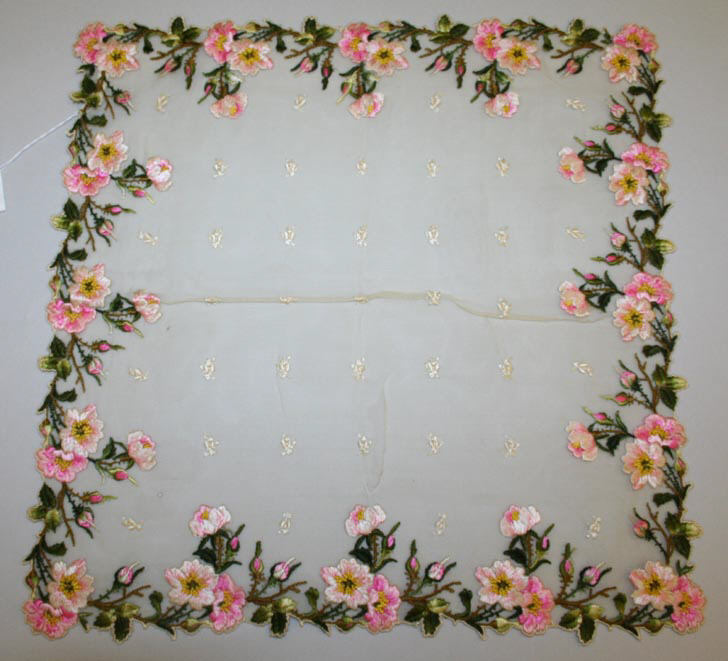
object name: handkerchief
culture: french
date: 1885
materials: silk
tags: flowers